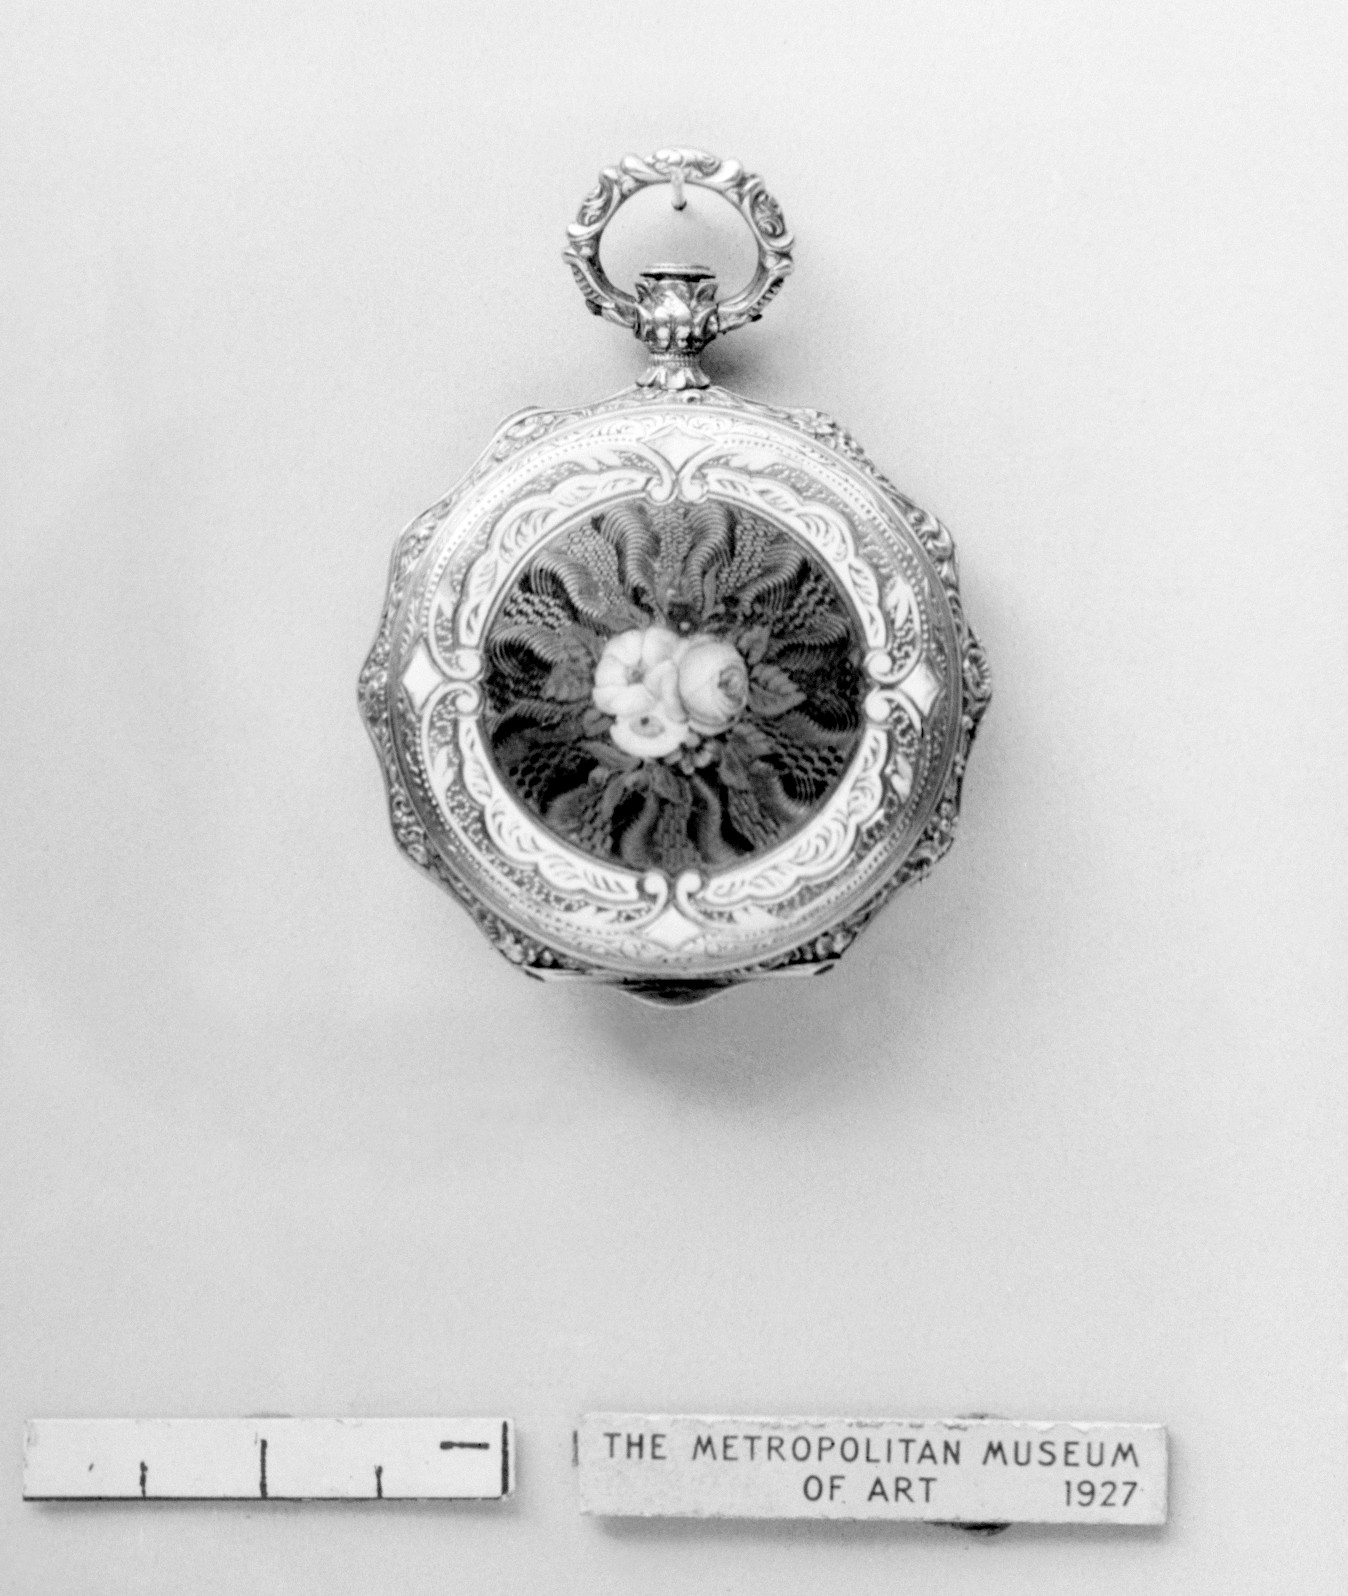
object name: watch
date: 1830-1840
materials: enamel, gold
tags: flowers